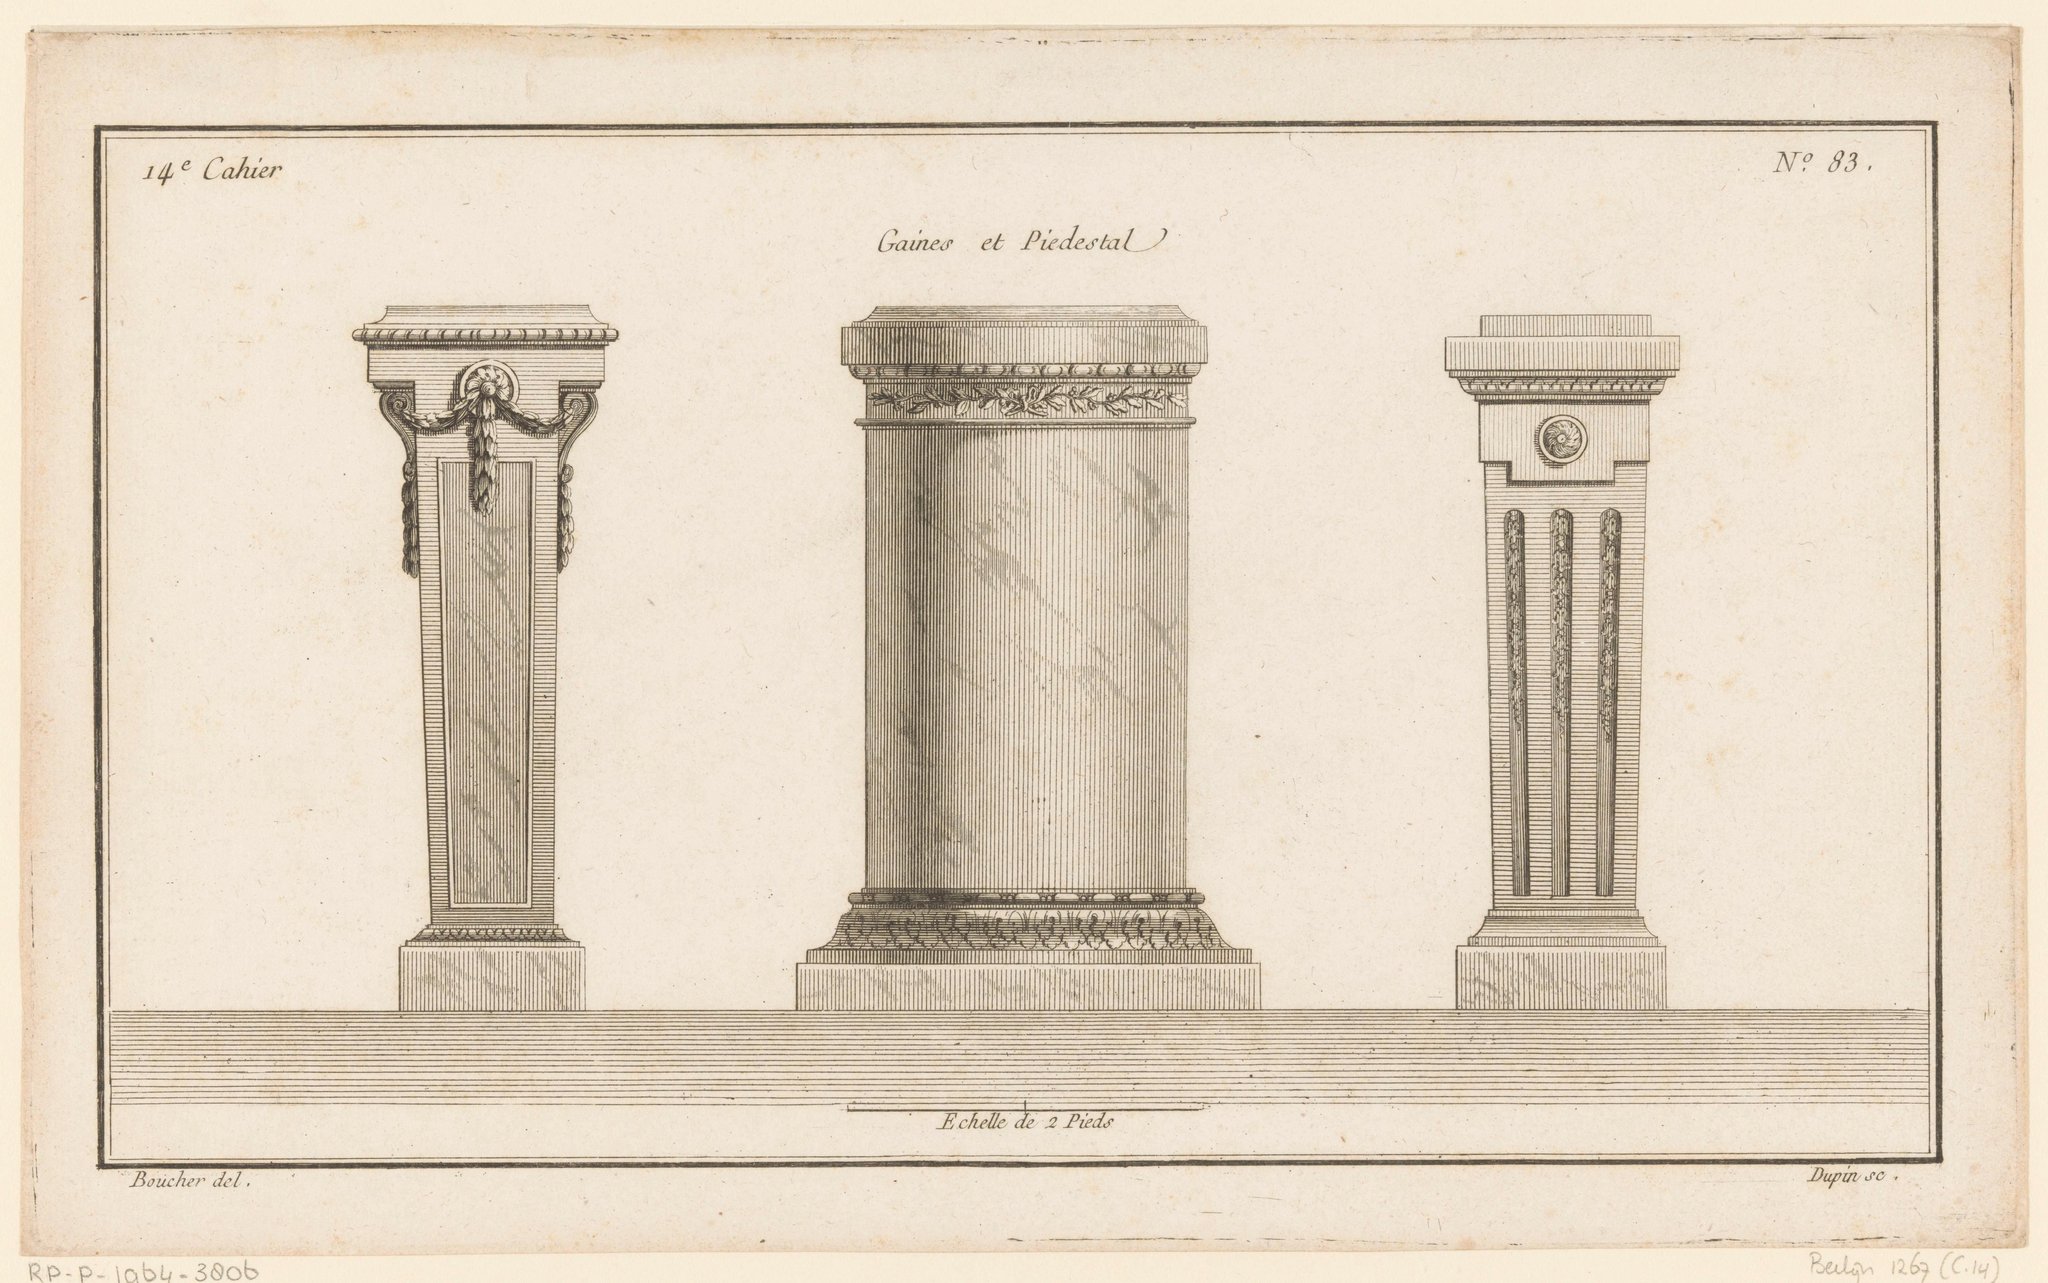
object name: ornament print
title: Gaines et Piedestal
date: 1772-1779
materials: paper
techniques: engraving, etching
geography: paris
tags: column, pillar ~ architecture, pedestal of a piece of sculpture (perhaps in the form of a herm), ornament derived from plant forms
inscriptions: collector's mark: Lugt 2760, collector's mark: Lugt 2228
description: Twee geornamenteerde voetstukken en een zuil met bladmotieven. Prentnummer 83.